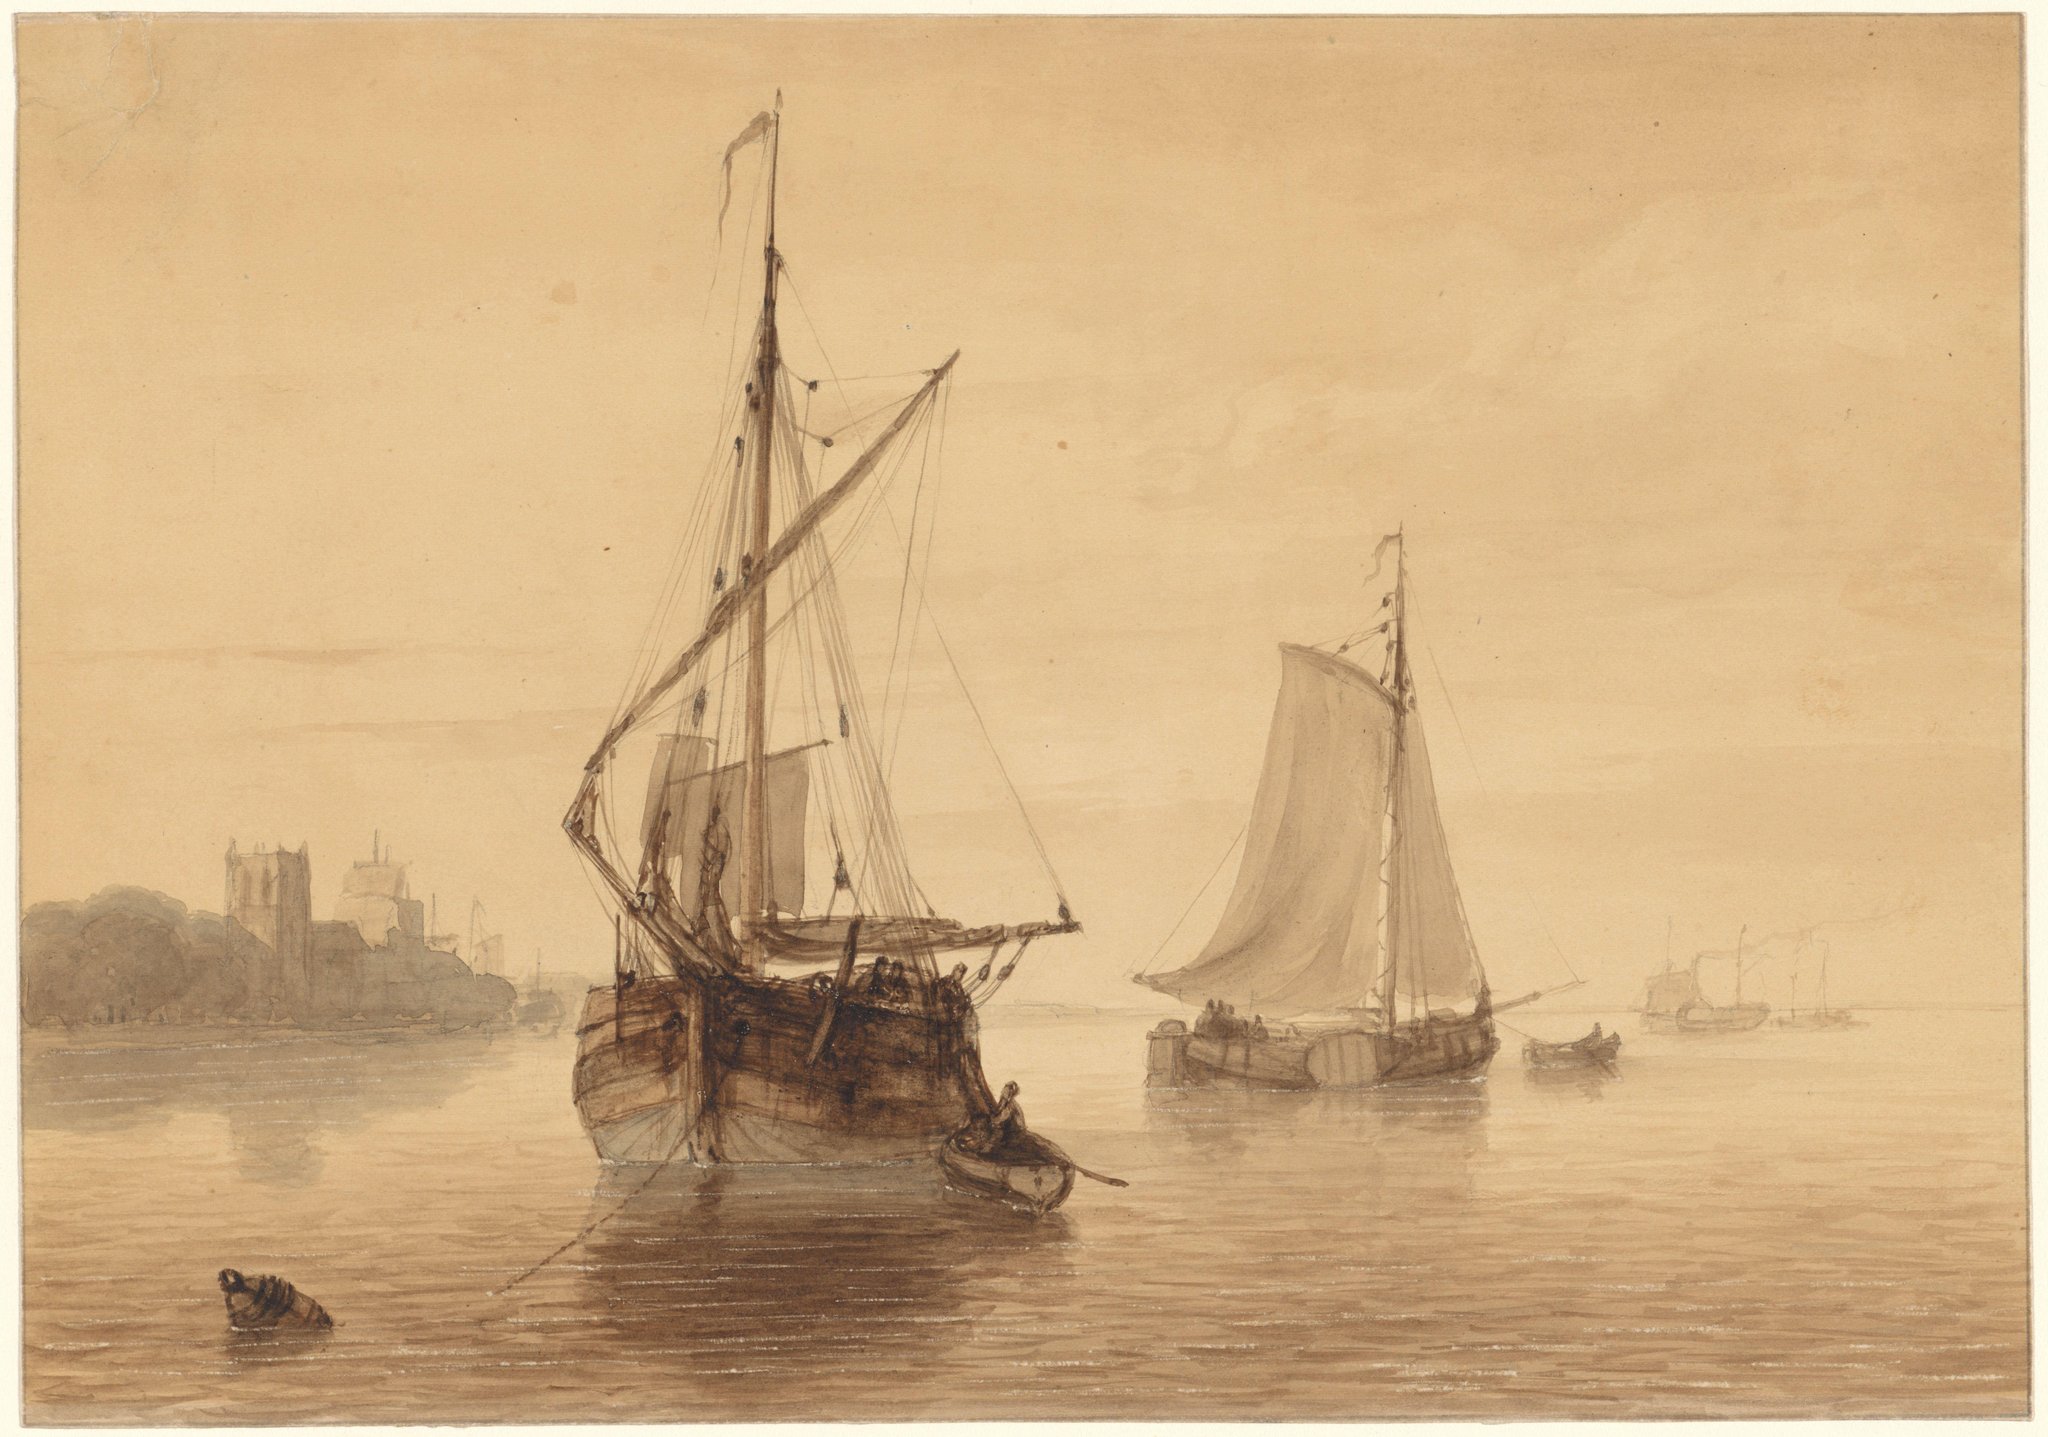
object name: drawing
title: Rivierlandschap met enkele schepen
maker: nicolaas johannes roosenboom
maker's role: draughtsman, print maker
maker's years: 1805-1880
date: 1815-1880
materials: ink, paper, pencil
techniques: brush, pen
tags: sailing-ship, sailing-boat, river